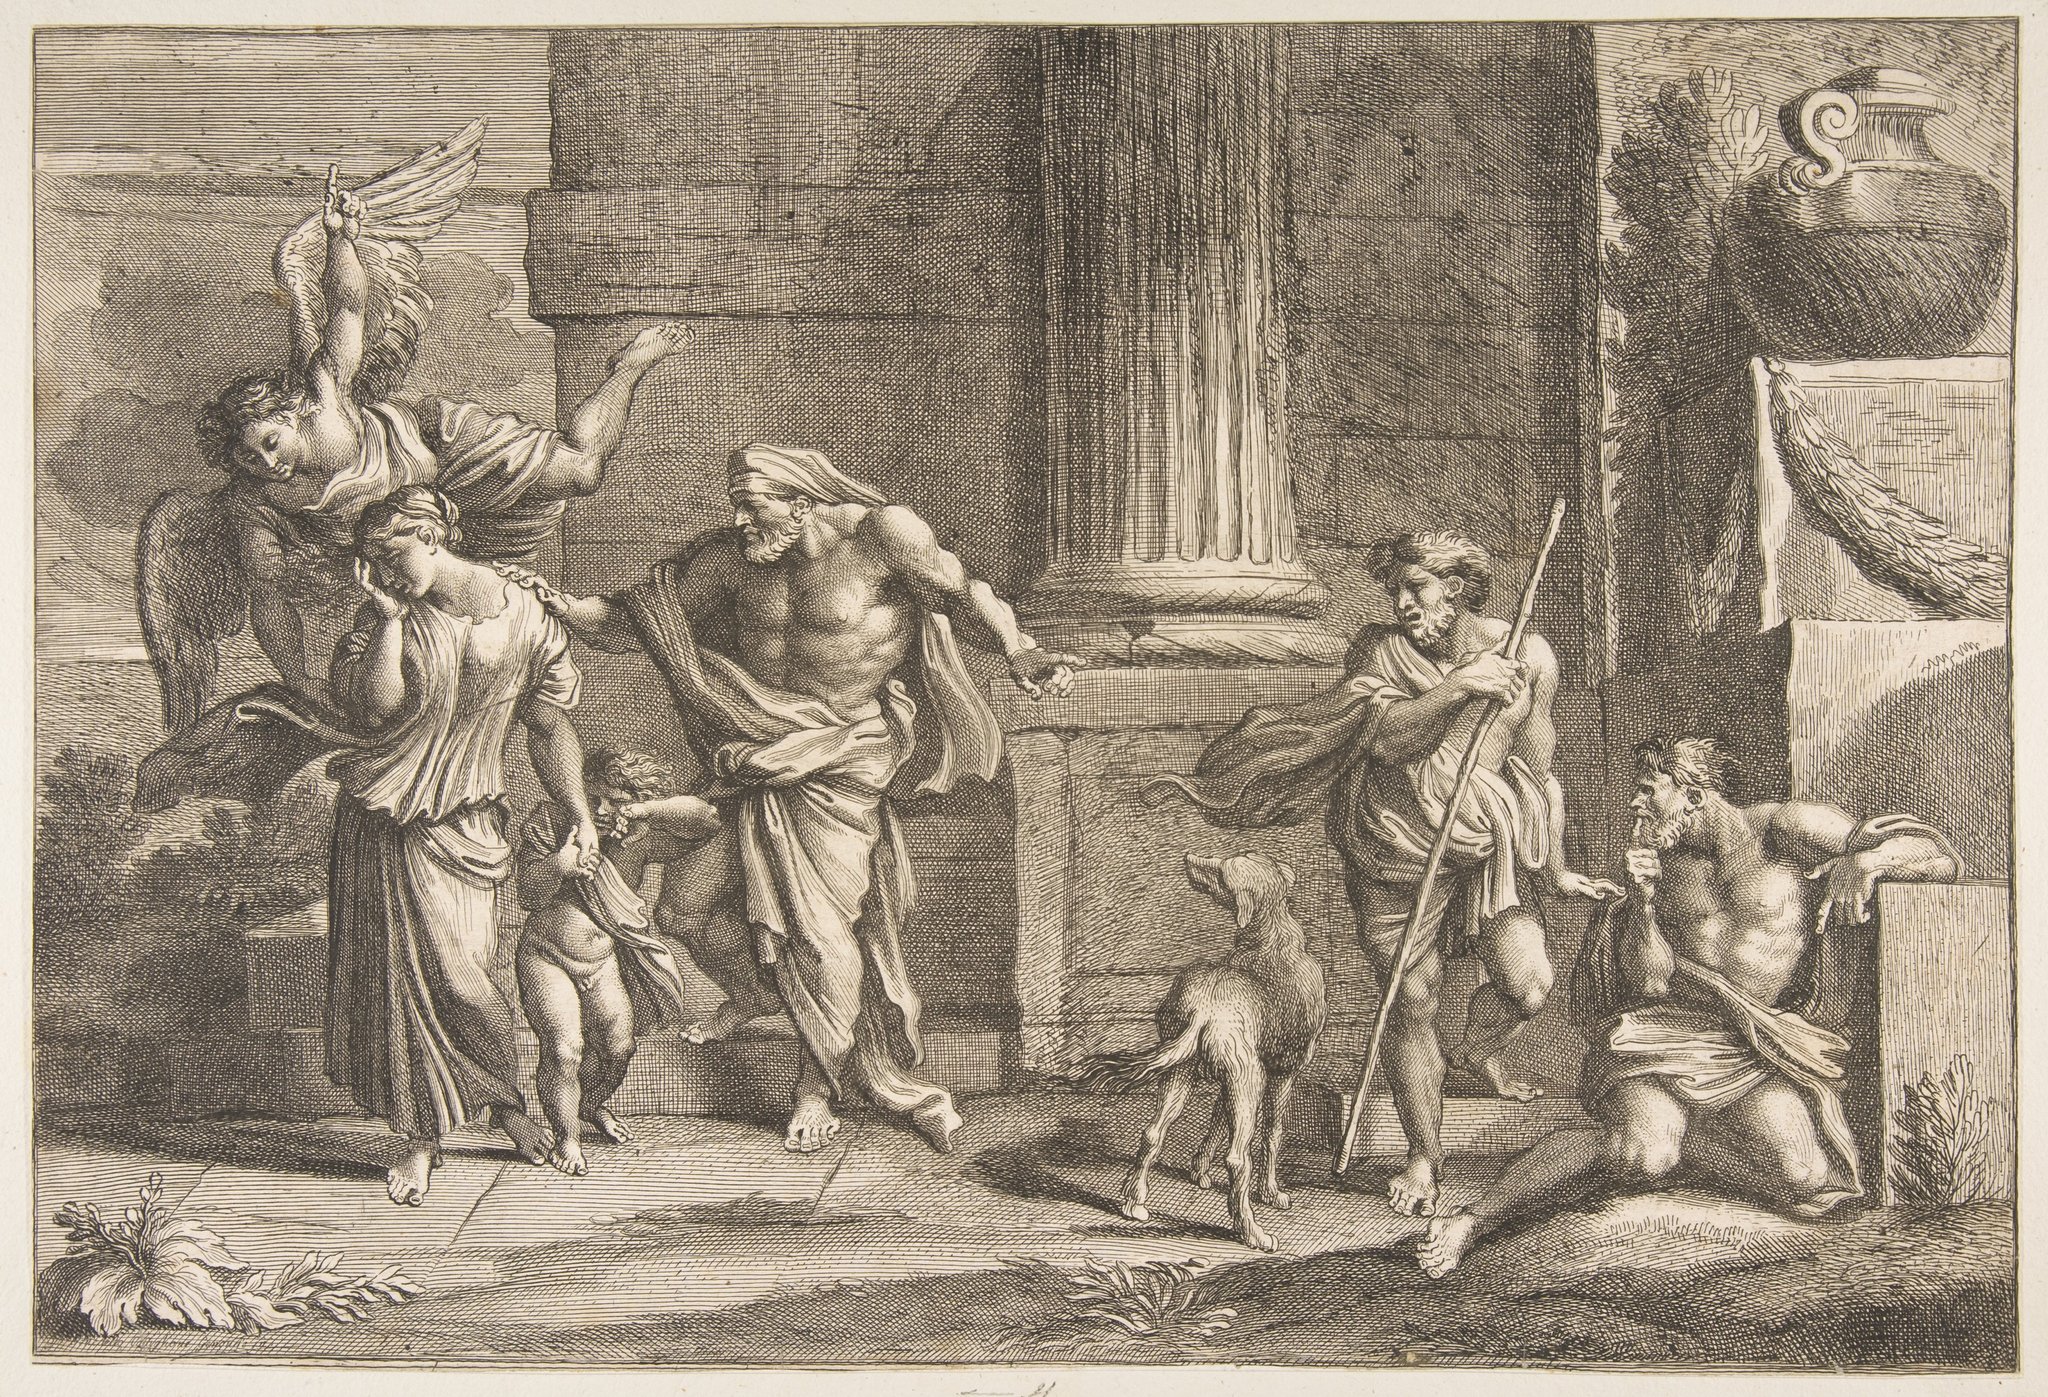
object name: print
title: The Expulsion of Hagar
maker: charles massé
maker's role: artist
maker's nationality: french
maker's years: 1631-1675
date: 1646-1670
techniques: etching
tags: men,women,dogs,angels